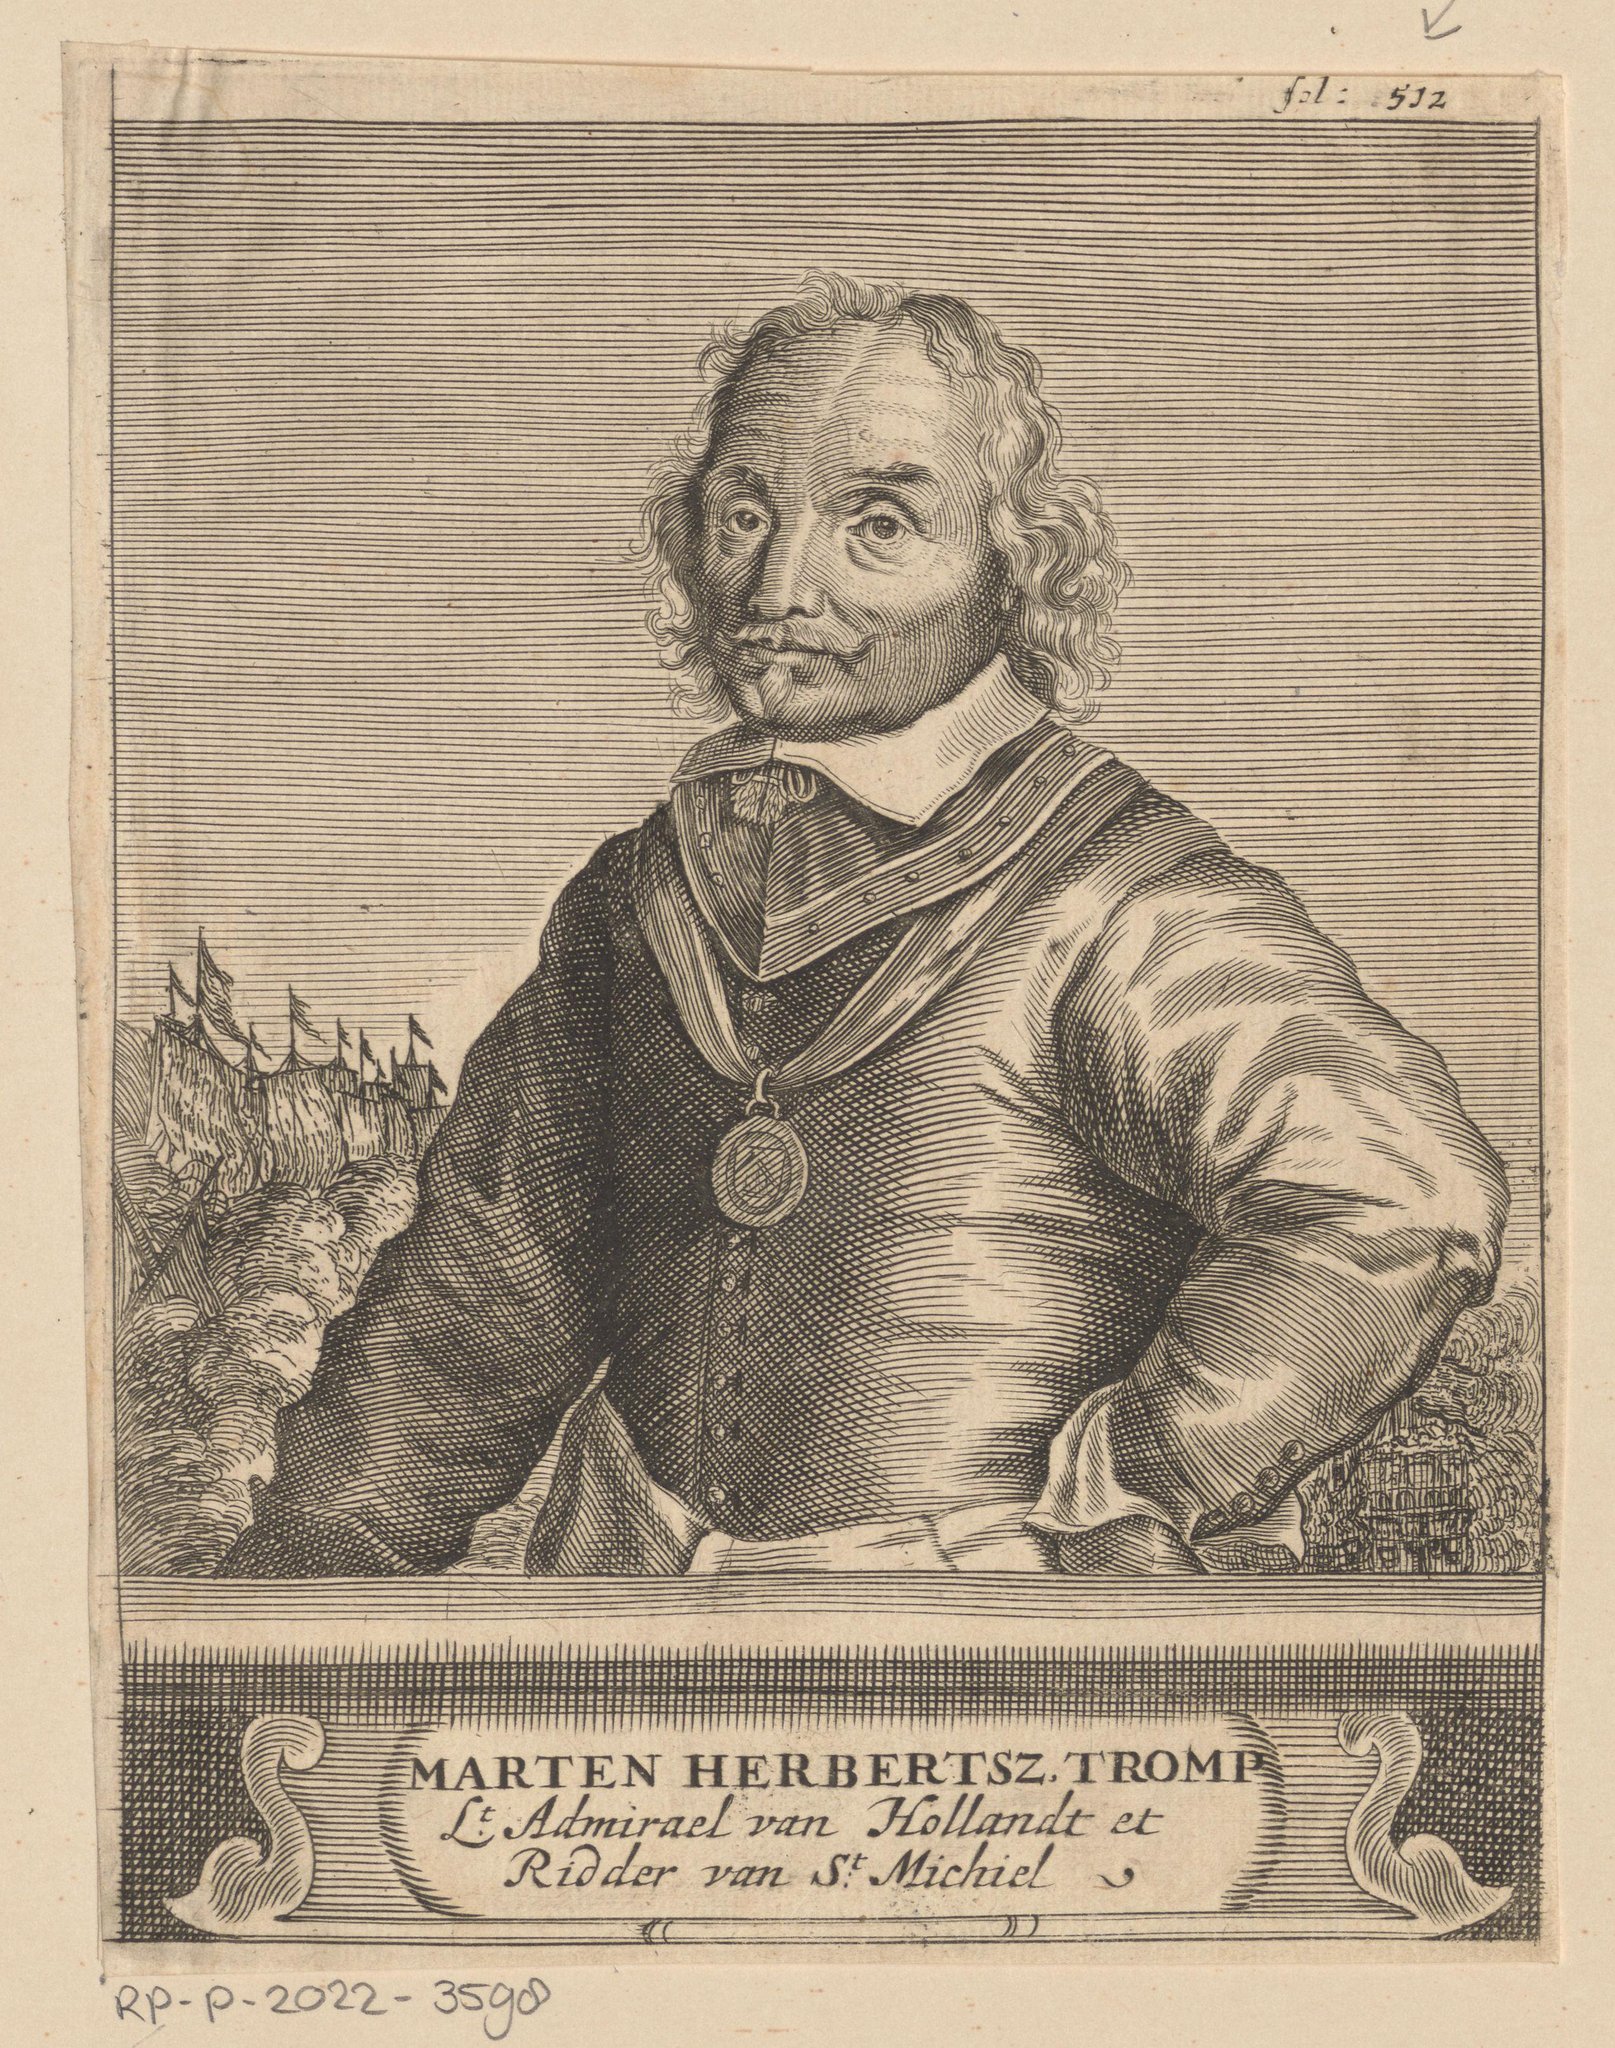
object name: book illustration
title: Portret van Maarten Harpertszoon Tromp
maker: Anonymous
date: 1683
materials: paper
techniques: engraving, etching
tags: brielle, maarten harpertszoon tromp, historical persons, medals and other marks of military honour, commander-in-chief, admiral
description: Prent waarschijnlijk uit: Bos, Lambert van den. Leeven en daaden der doorluchtigste Zee-helden, (...). Amsterdam: J. ten Hoorn en J. Bouman, 1683, p. 512.